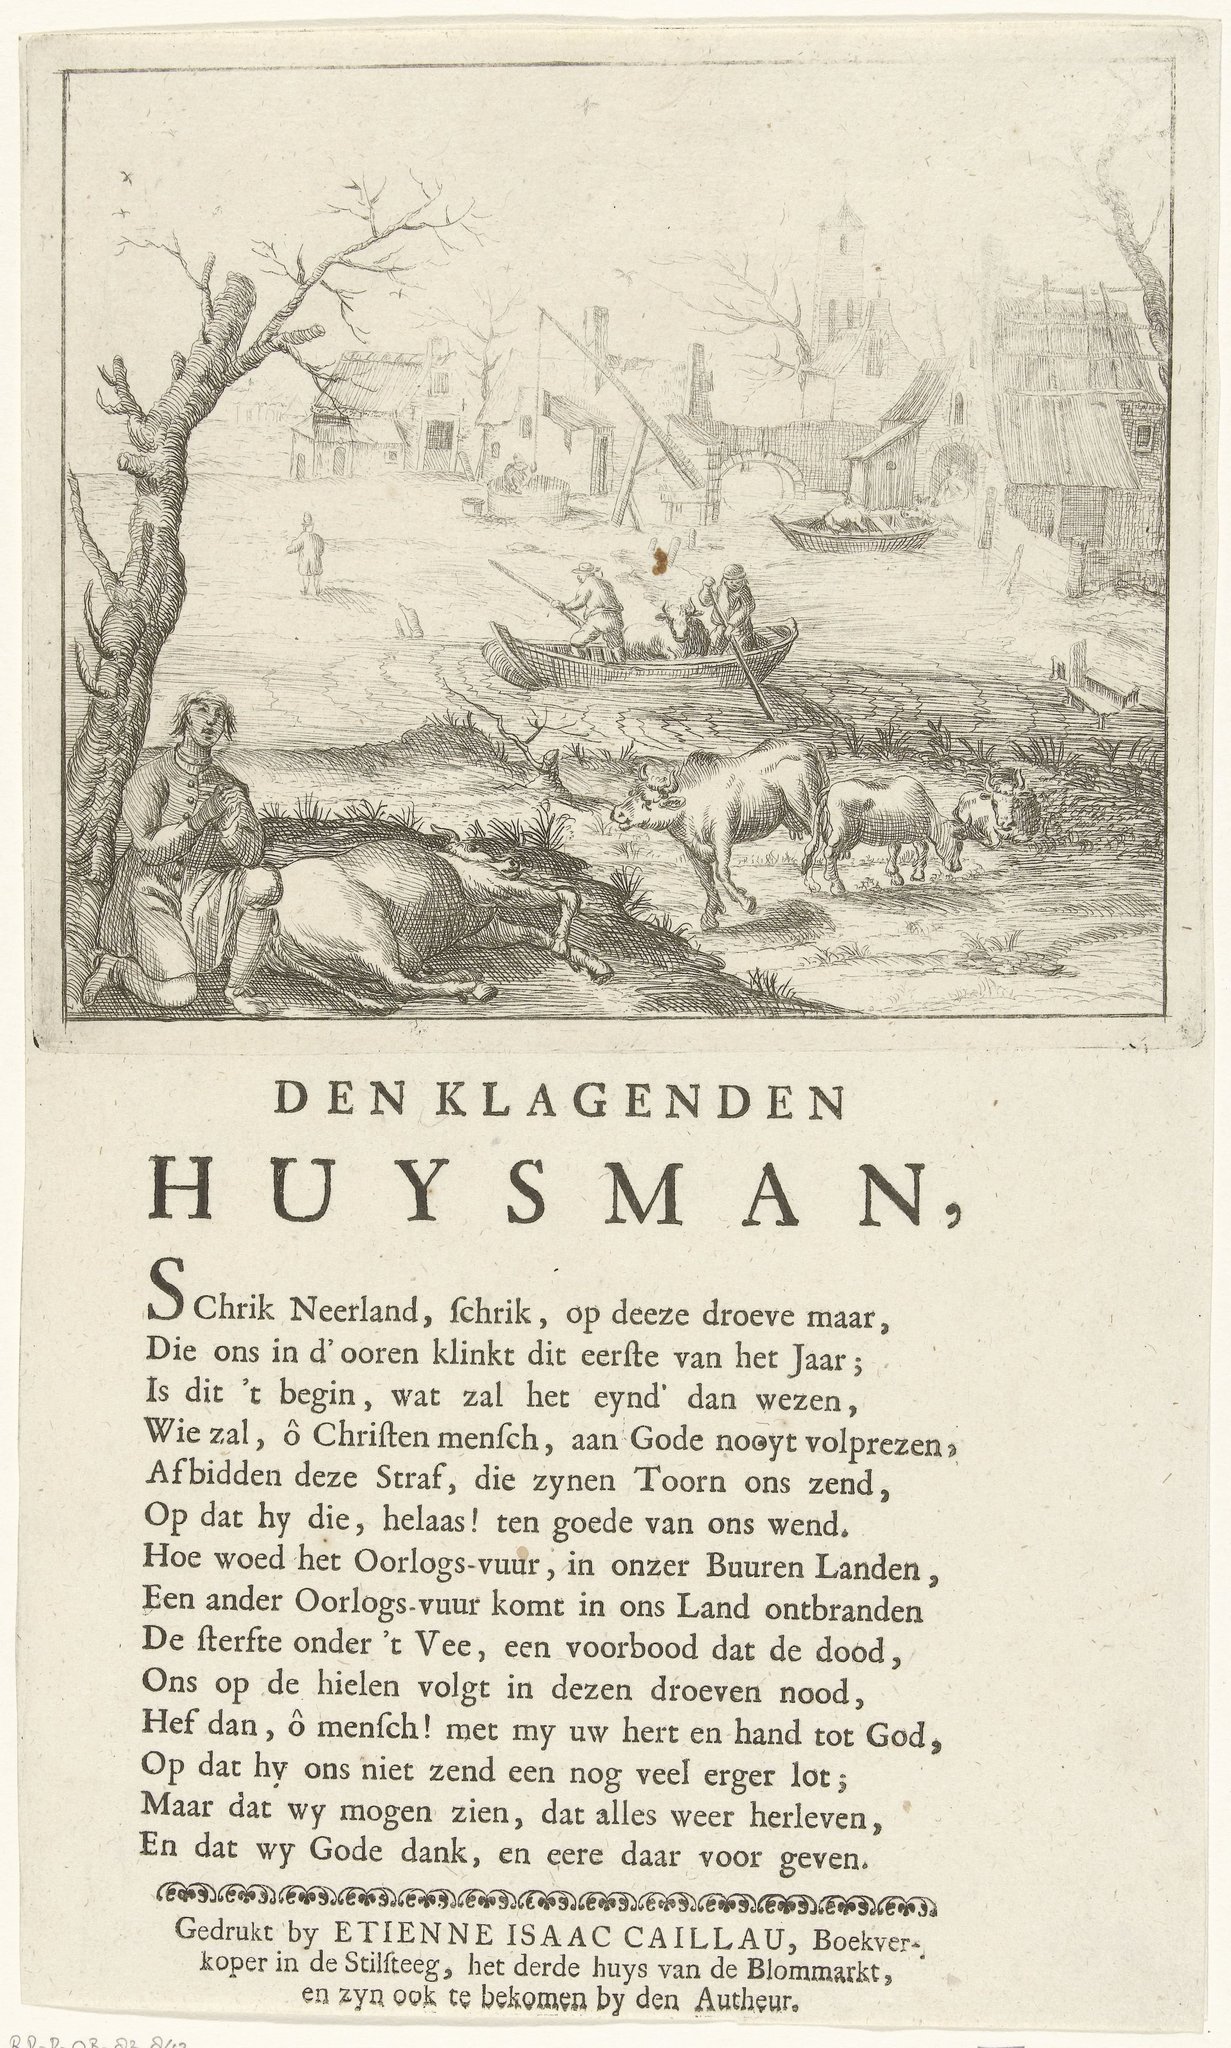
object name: print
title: Den Klagenden Huysman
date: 1745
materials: paper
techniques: etching, letterpress printing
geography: amsterdam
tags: hoofed animals (+ animal(s) being sick; having a disease), cow, netherlands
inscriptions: collector's mark: Lugt 2228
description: Een boer knielt naast een dode koe en bidt tot God om verlossing van de vee- of runderpest die het land treft in 1745. Op de achtergrond huizen aan het water en het afvoer van gestorven vee in schuitjes. Op het blad onder de plaat een vers in 14 regels.